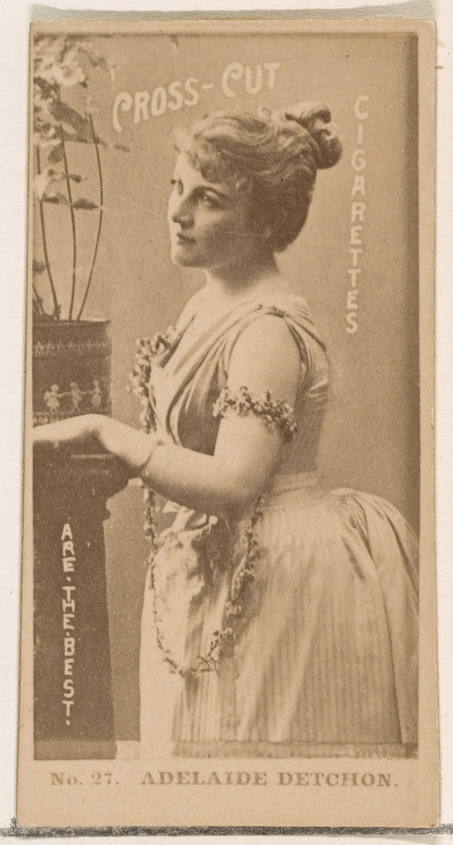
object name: print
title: Card Number 27, Adelaide Detchon, from the Actors and Actresses series (N145-2) issued by Duke Sons & Co. to promote Cross Cut Cigarettes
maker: w. duke, sons & co.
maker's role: publisher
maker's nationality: american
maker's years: 1870-1920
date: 1880-1889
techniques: albumen silver print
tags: portraits,women,actresses